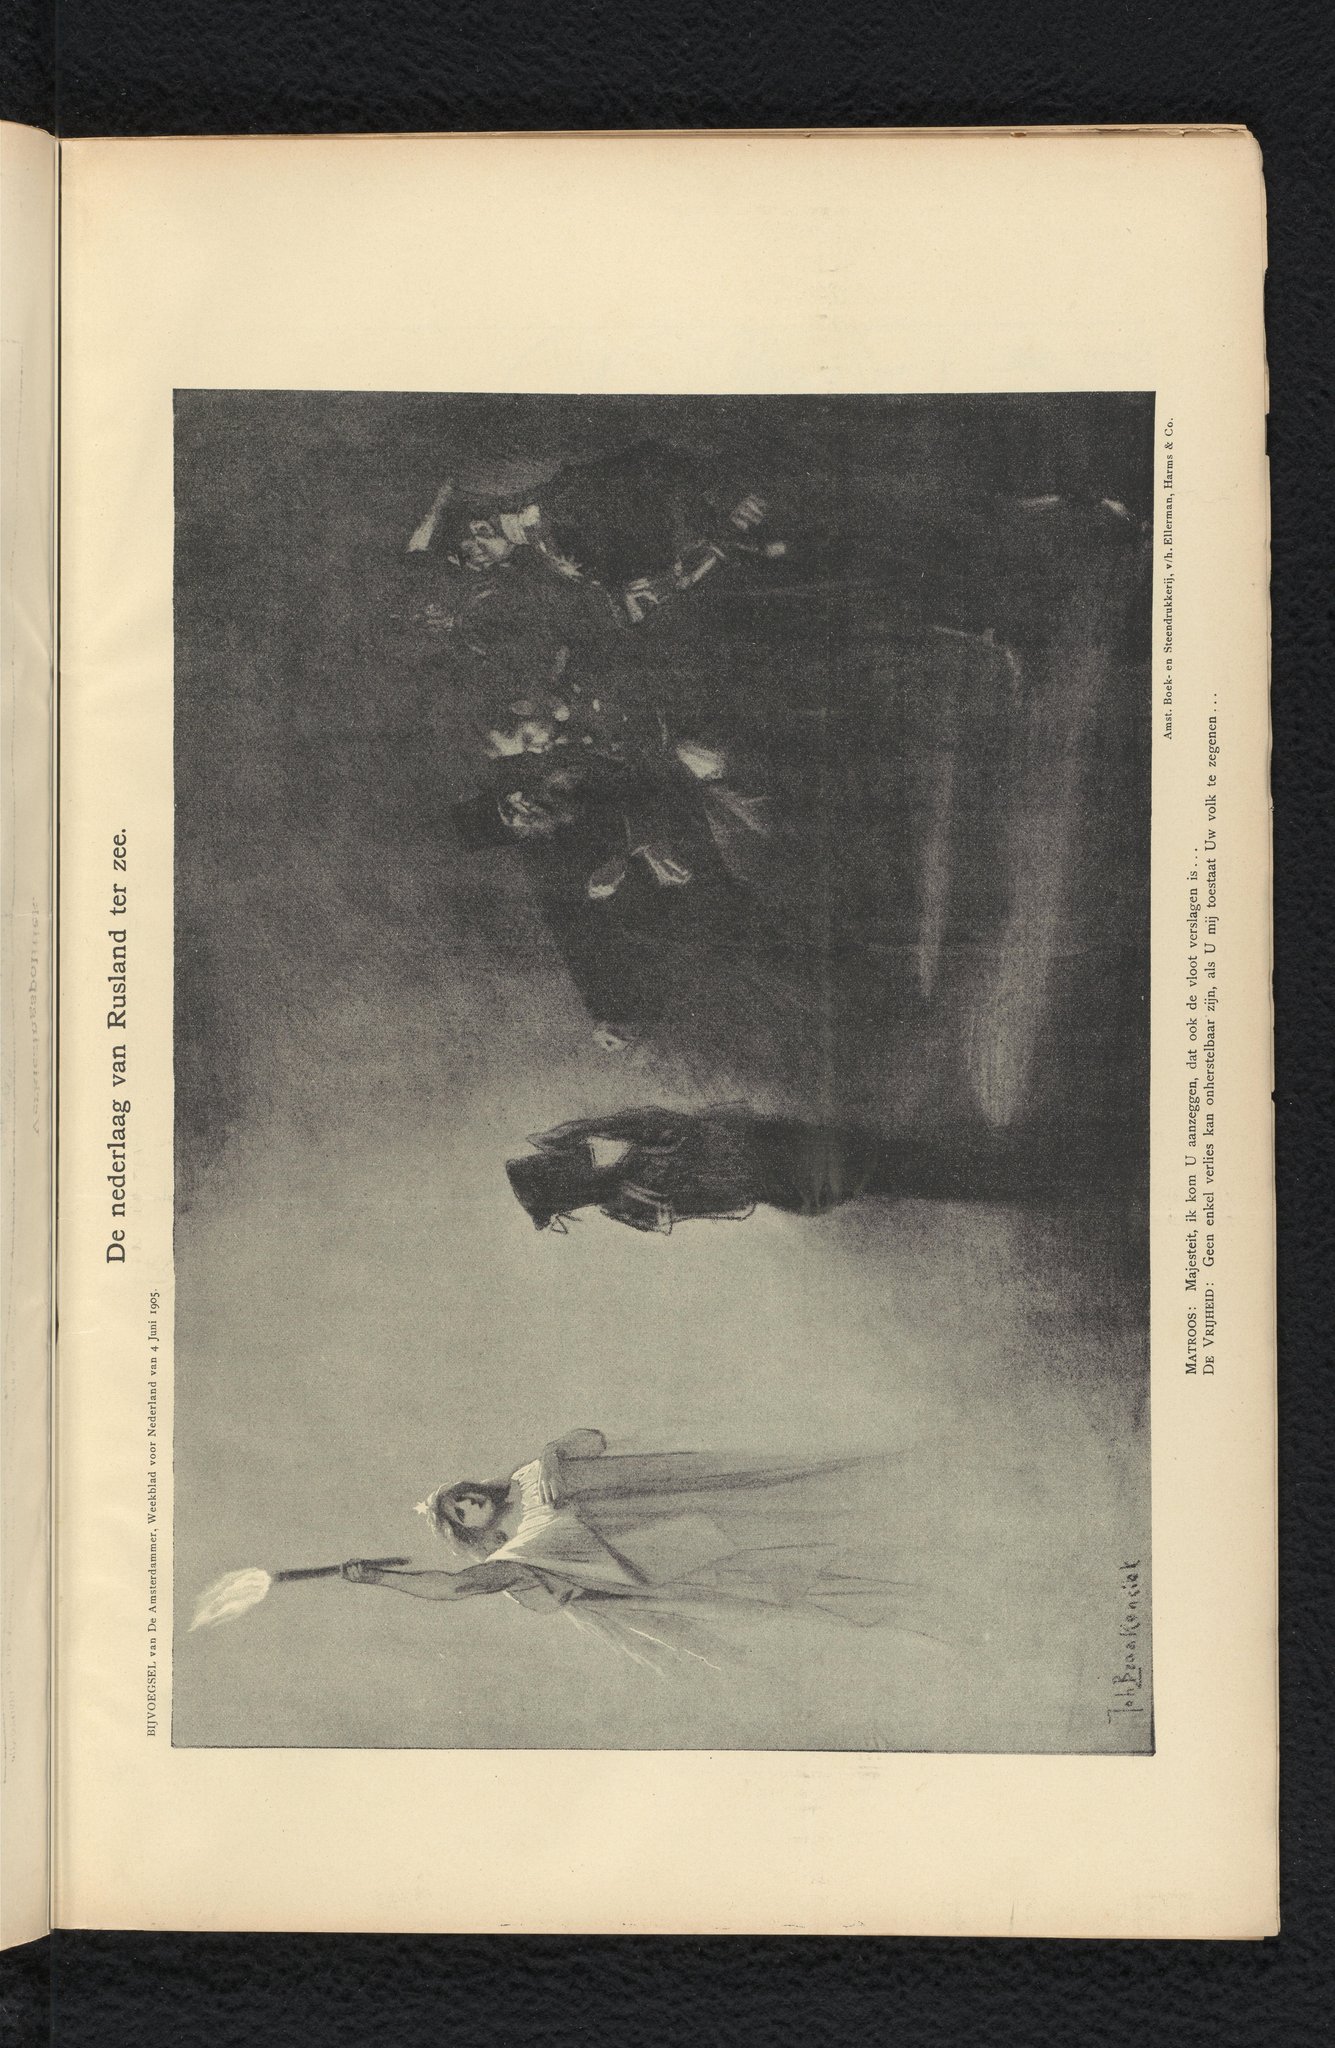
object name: photomechanical print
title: De nederlaag van Rusland ter zee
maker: johan braakensiek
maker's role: draughtsman, print maker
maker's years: 1858-1940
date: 1905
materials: paper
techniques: autotype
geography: netherlands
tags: torch, the defeated (after the battle), political caricatures and satires, freedom, liberty; 'libertà' (ripa) (+ abstract concept represented by female figure)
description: Een matroos komt de Russische tsaar Nicolaas II, zittend in het duister, het slechte nieuws brengen dat de Russische vloot verslagen is door de Japanners (in de Slag bij Tsushima, 27-28 mei). Links in het licht de personificatie van de Vrijheid met een brandende toorts.